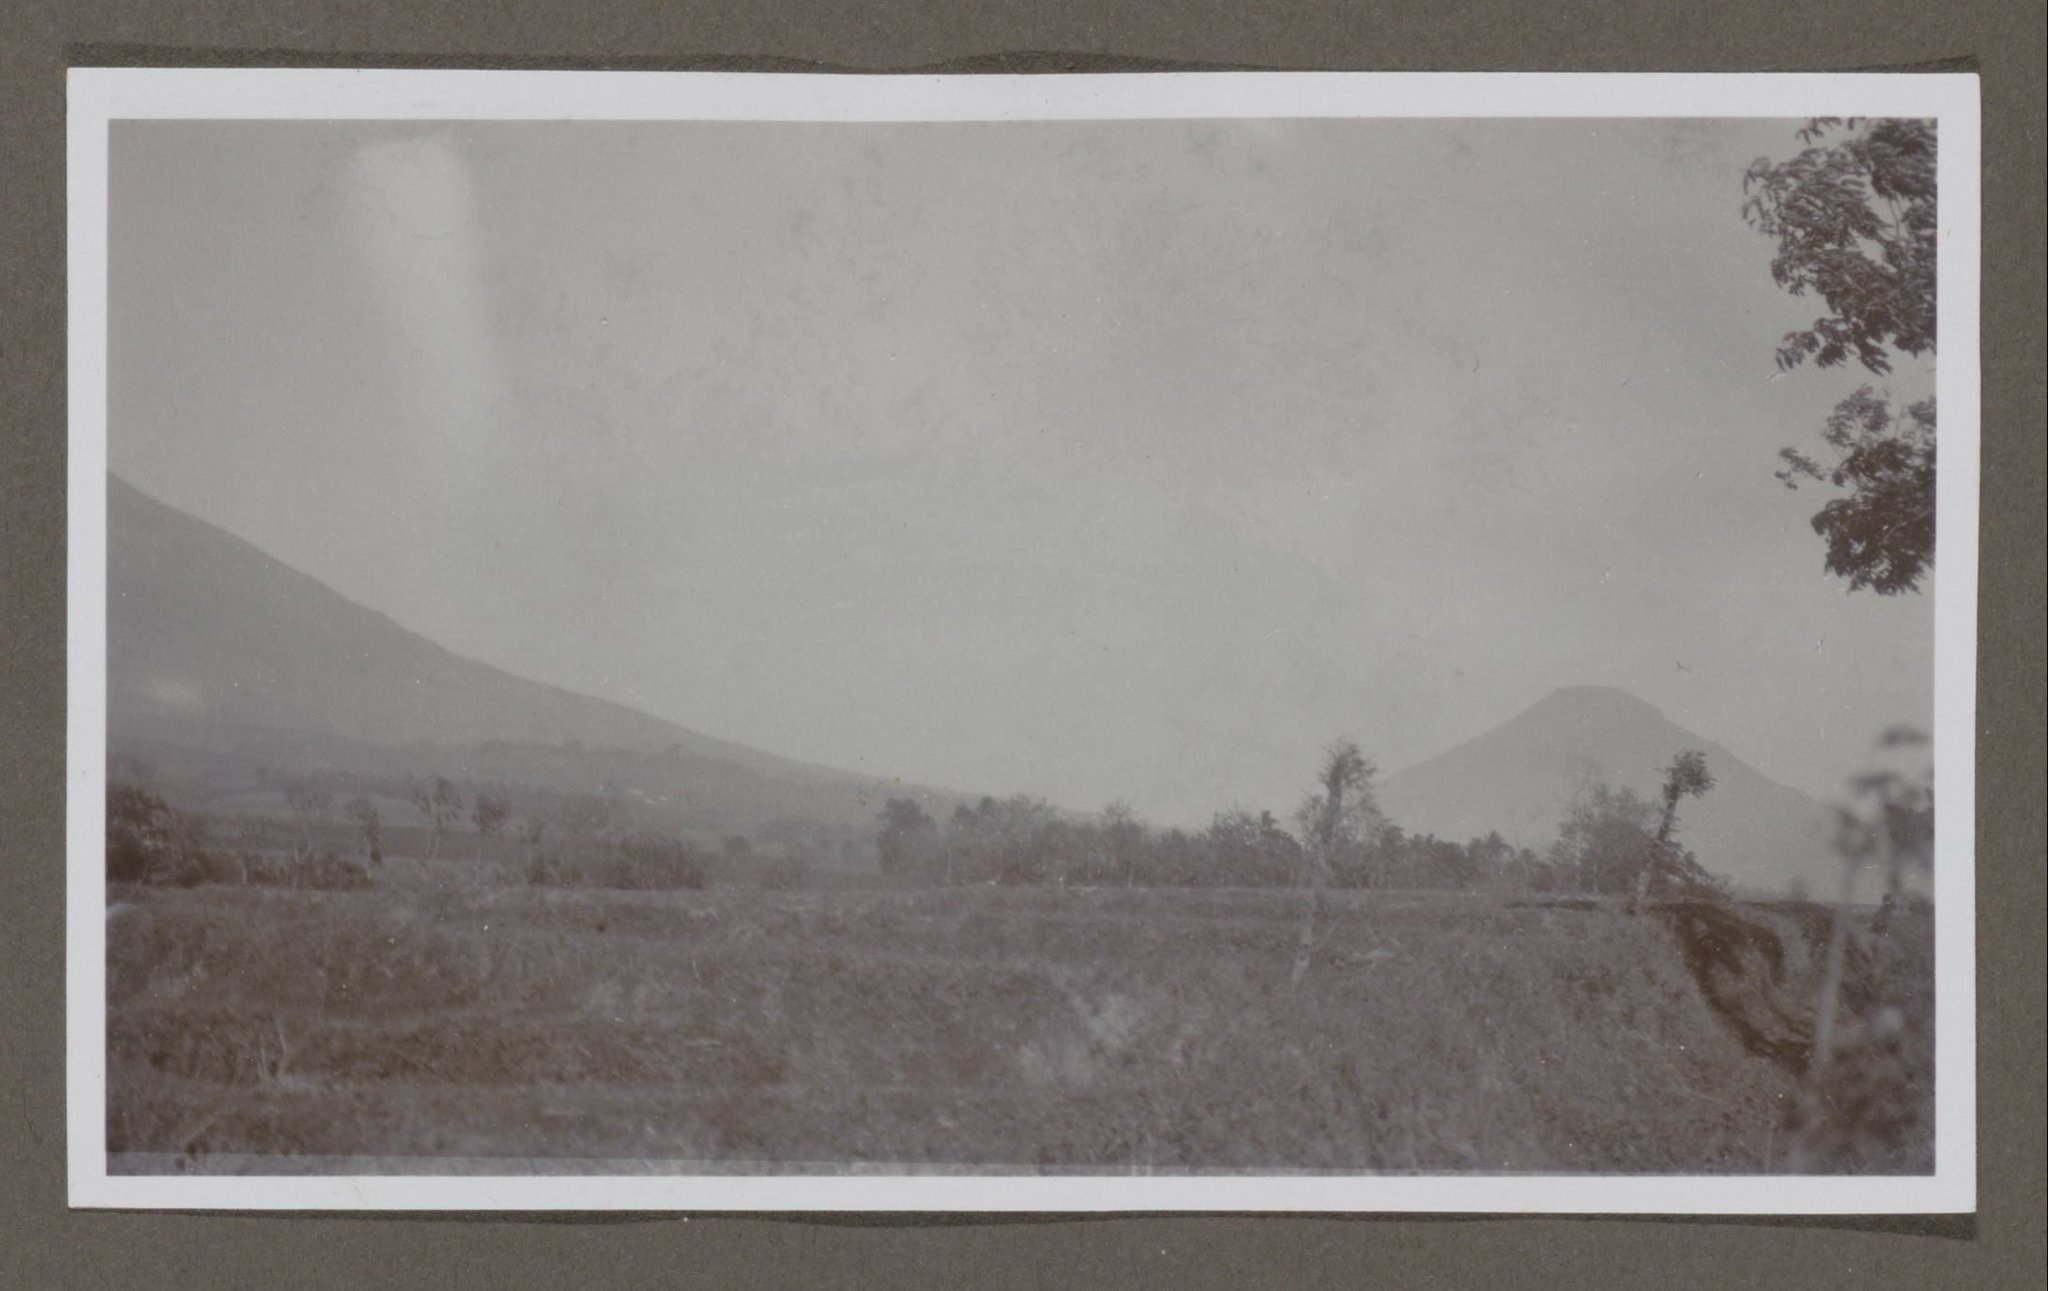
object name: photograph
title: Landschap met op de achtergrond twee vulkanen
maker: Anonymous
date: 1920-1930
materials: photographic support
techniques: gelatin silver print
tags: volcano, dutch east indies, the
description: Onderdeel van familiealbum Nederlands-Indië.